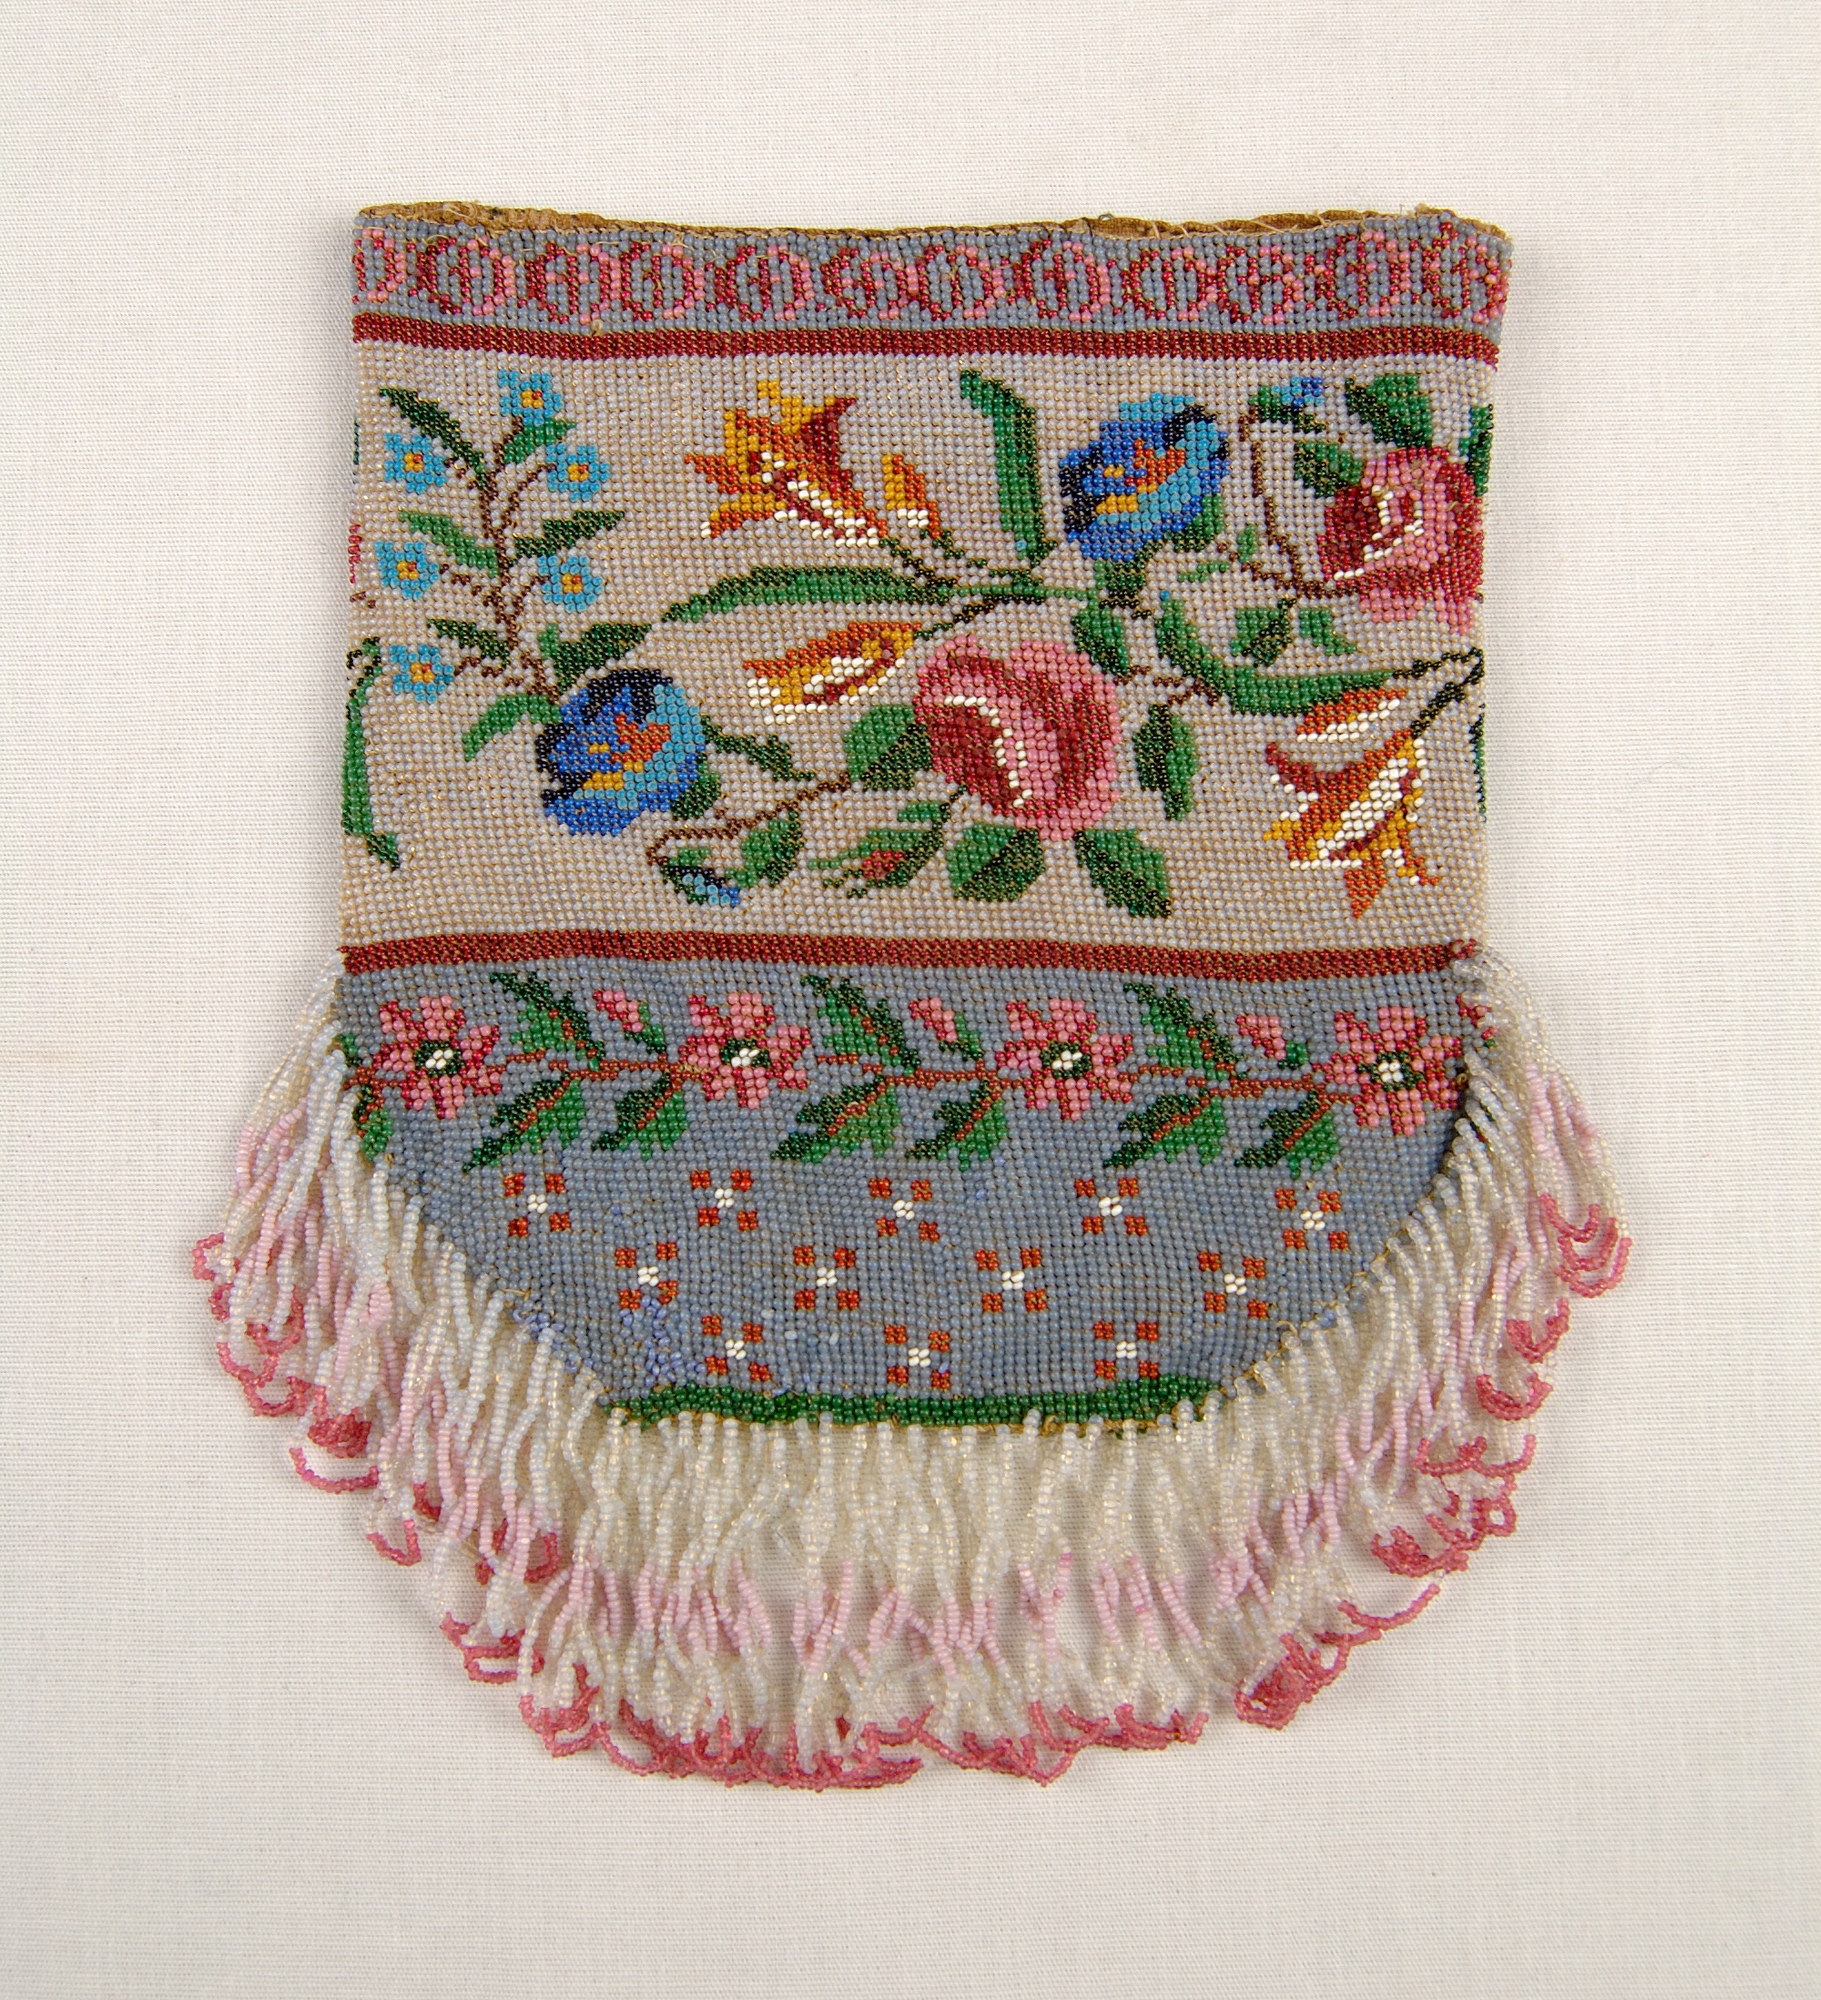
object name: pouch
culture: american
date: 1830-1860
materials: cotton, glass, linen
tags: flowers